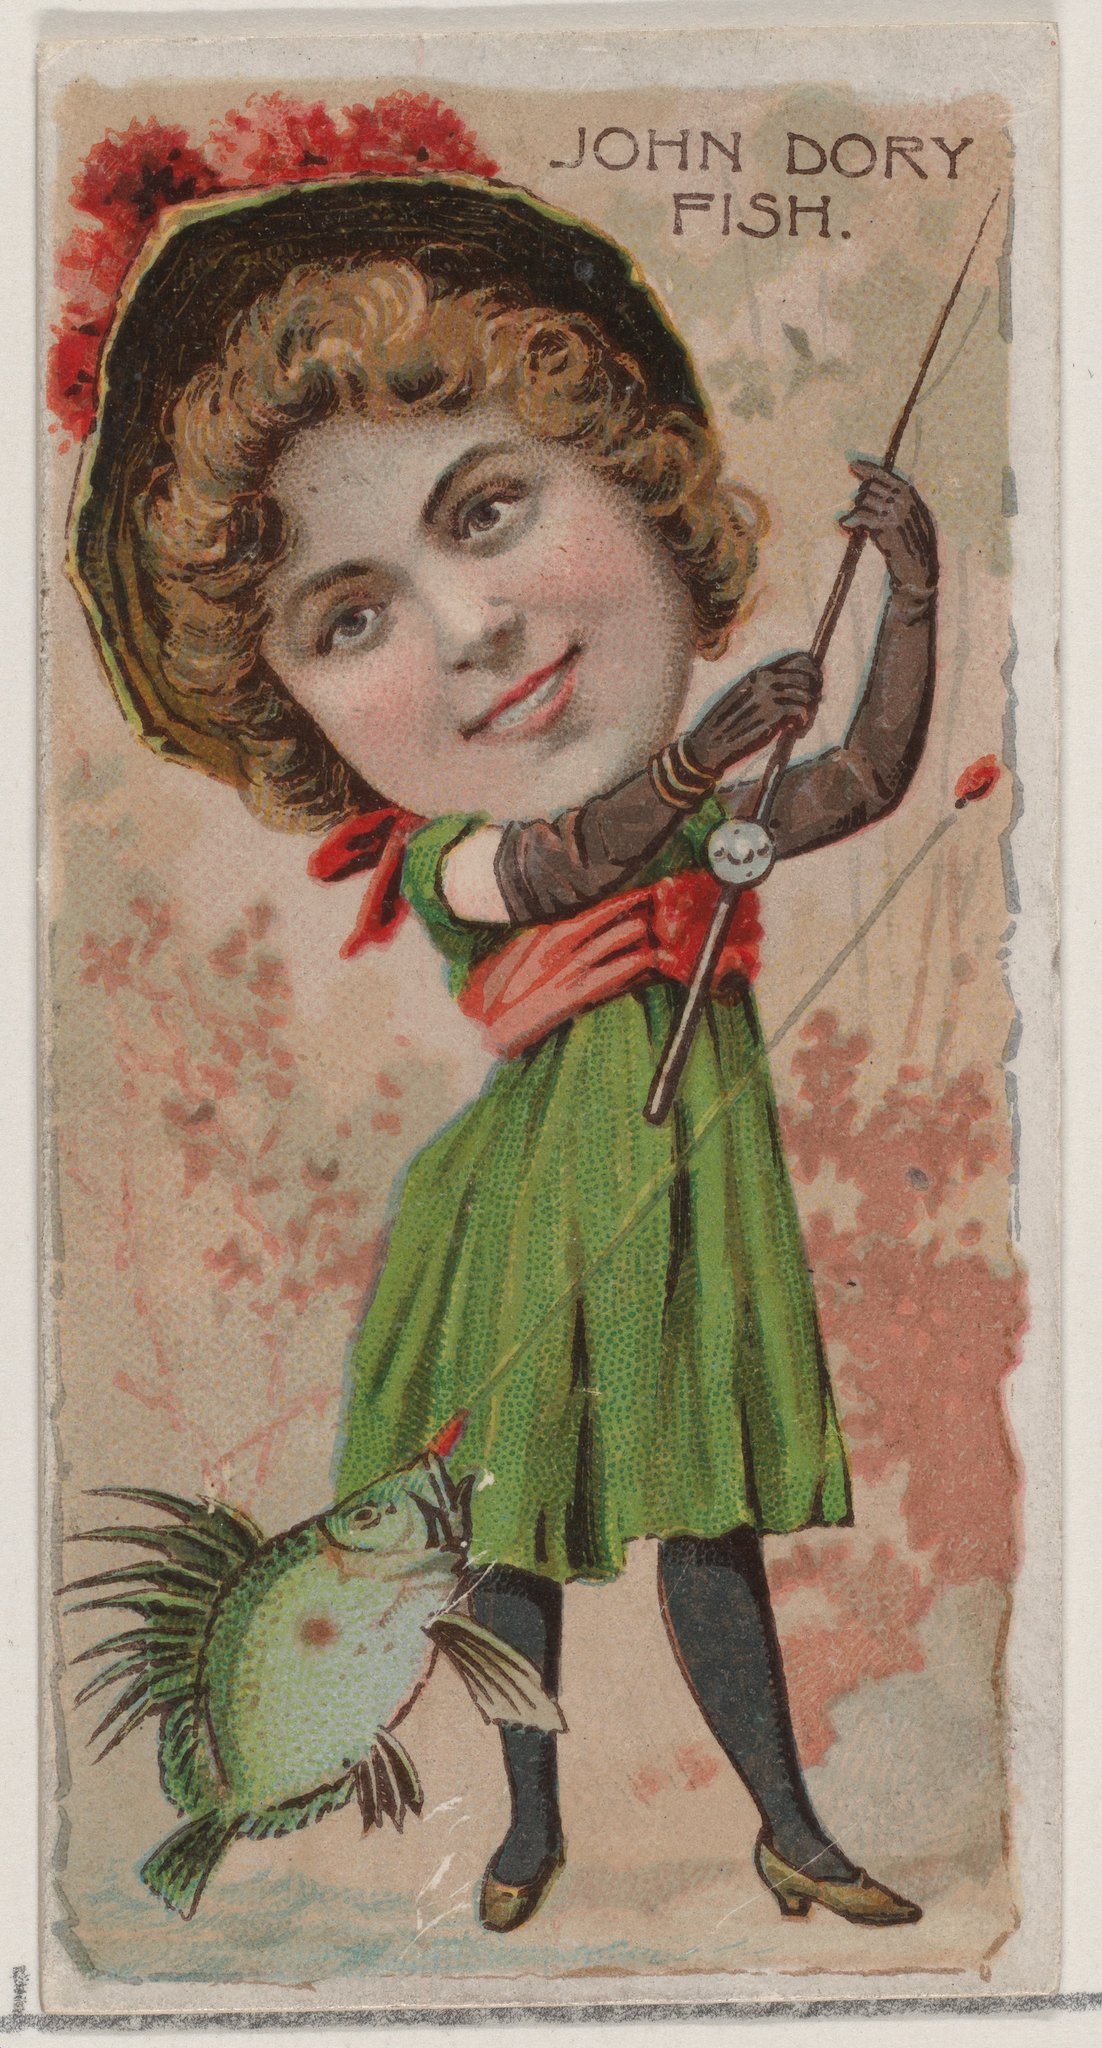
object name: print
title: John Dory Fish, from the series Fishers and Fish (N74) for Duke brand cigarettes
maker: knapp & company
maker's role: lithographer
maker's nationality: american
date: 1888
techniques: color lithograph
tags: women,fishing,fish